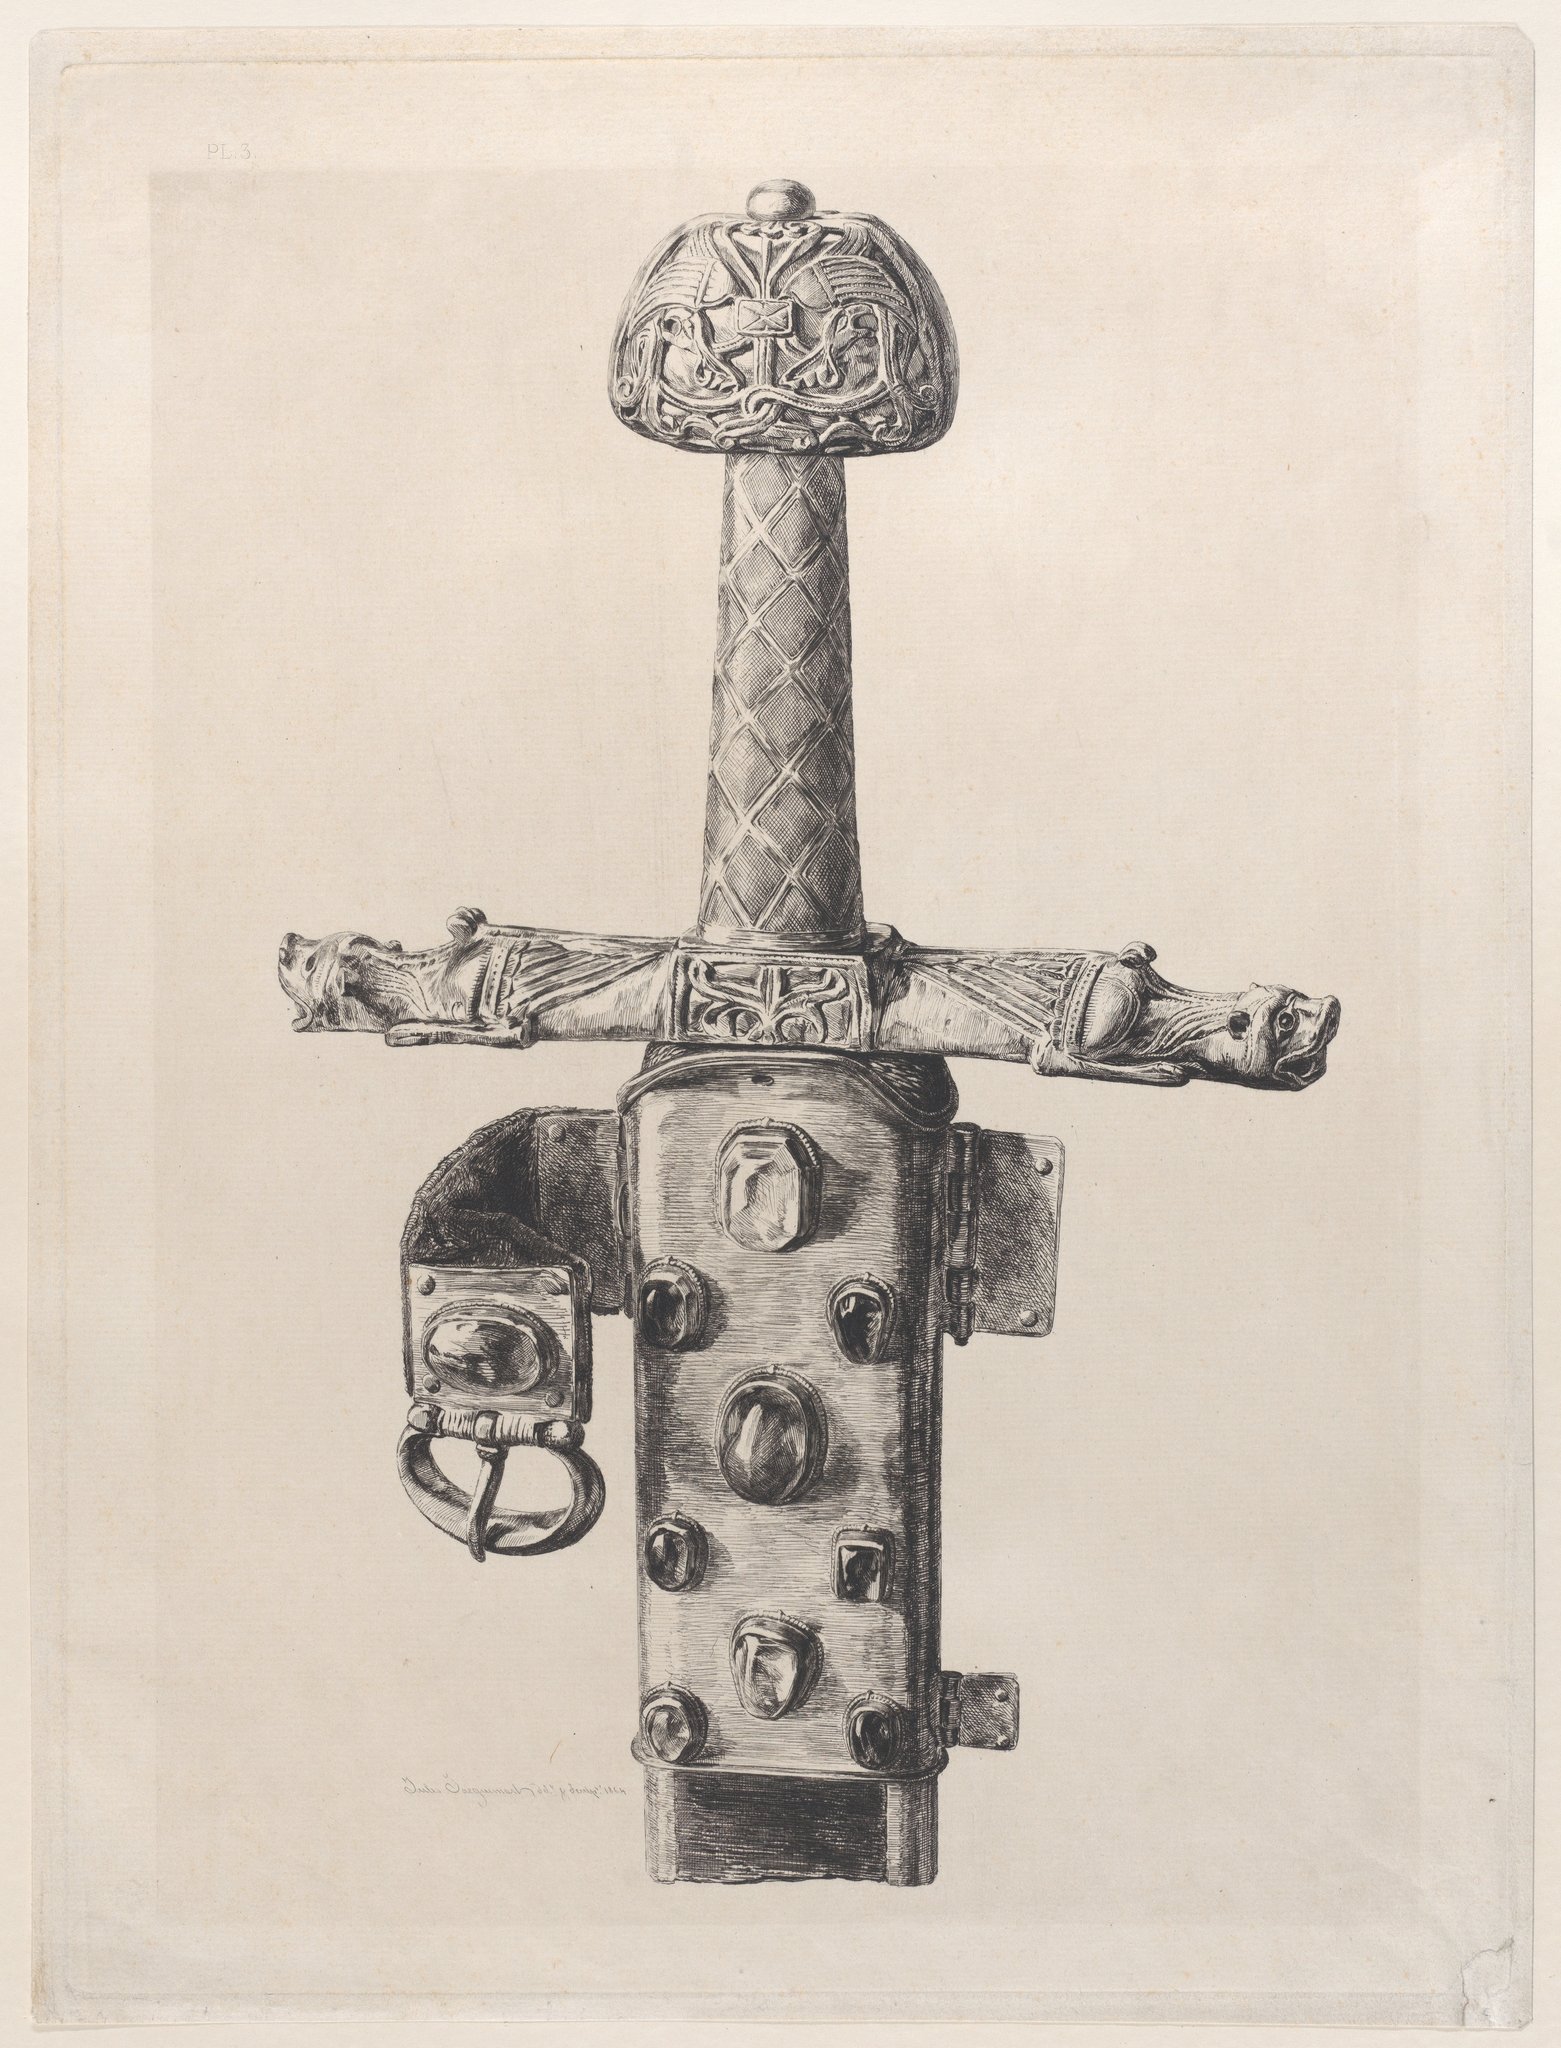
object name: print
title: Sword of Charlemagne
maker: jules-ferdinand jacquemart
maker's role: artist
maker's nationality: french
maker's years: 1837-1880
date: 1864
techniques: etching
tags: swords